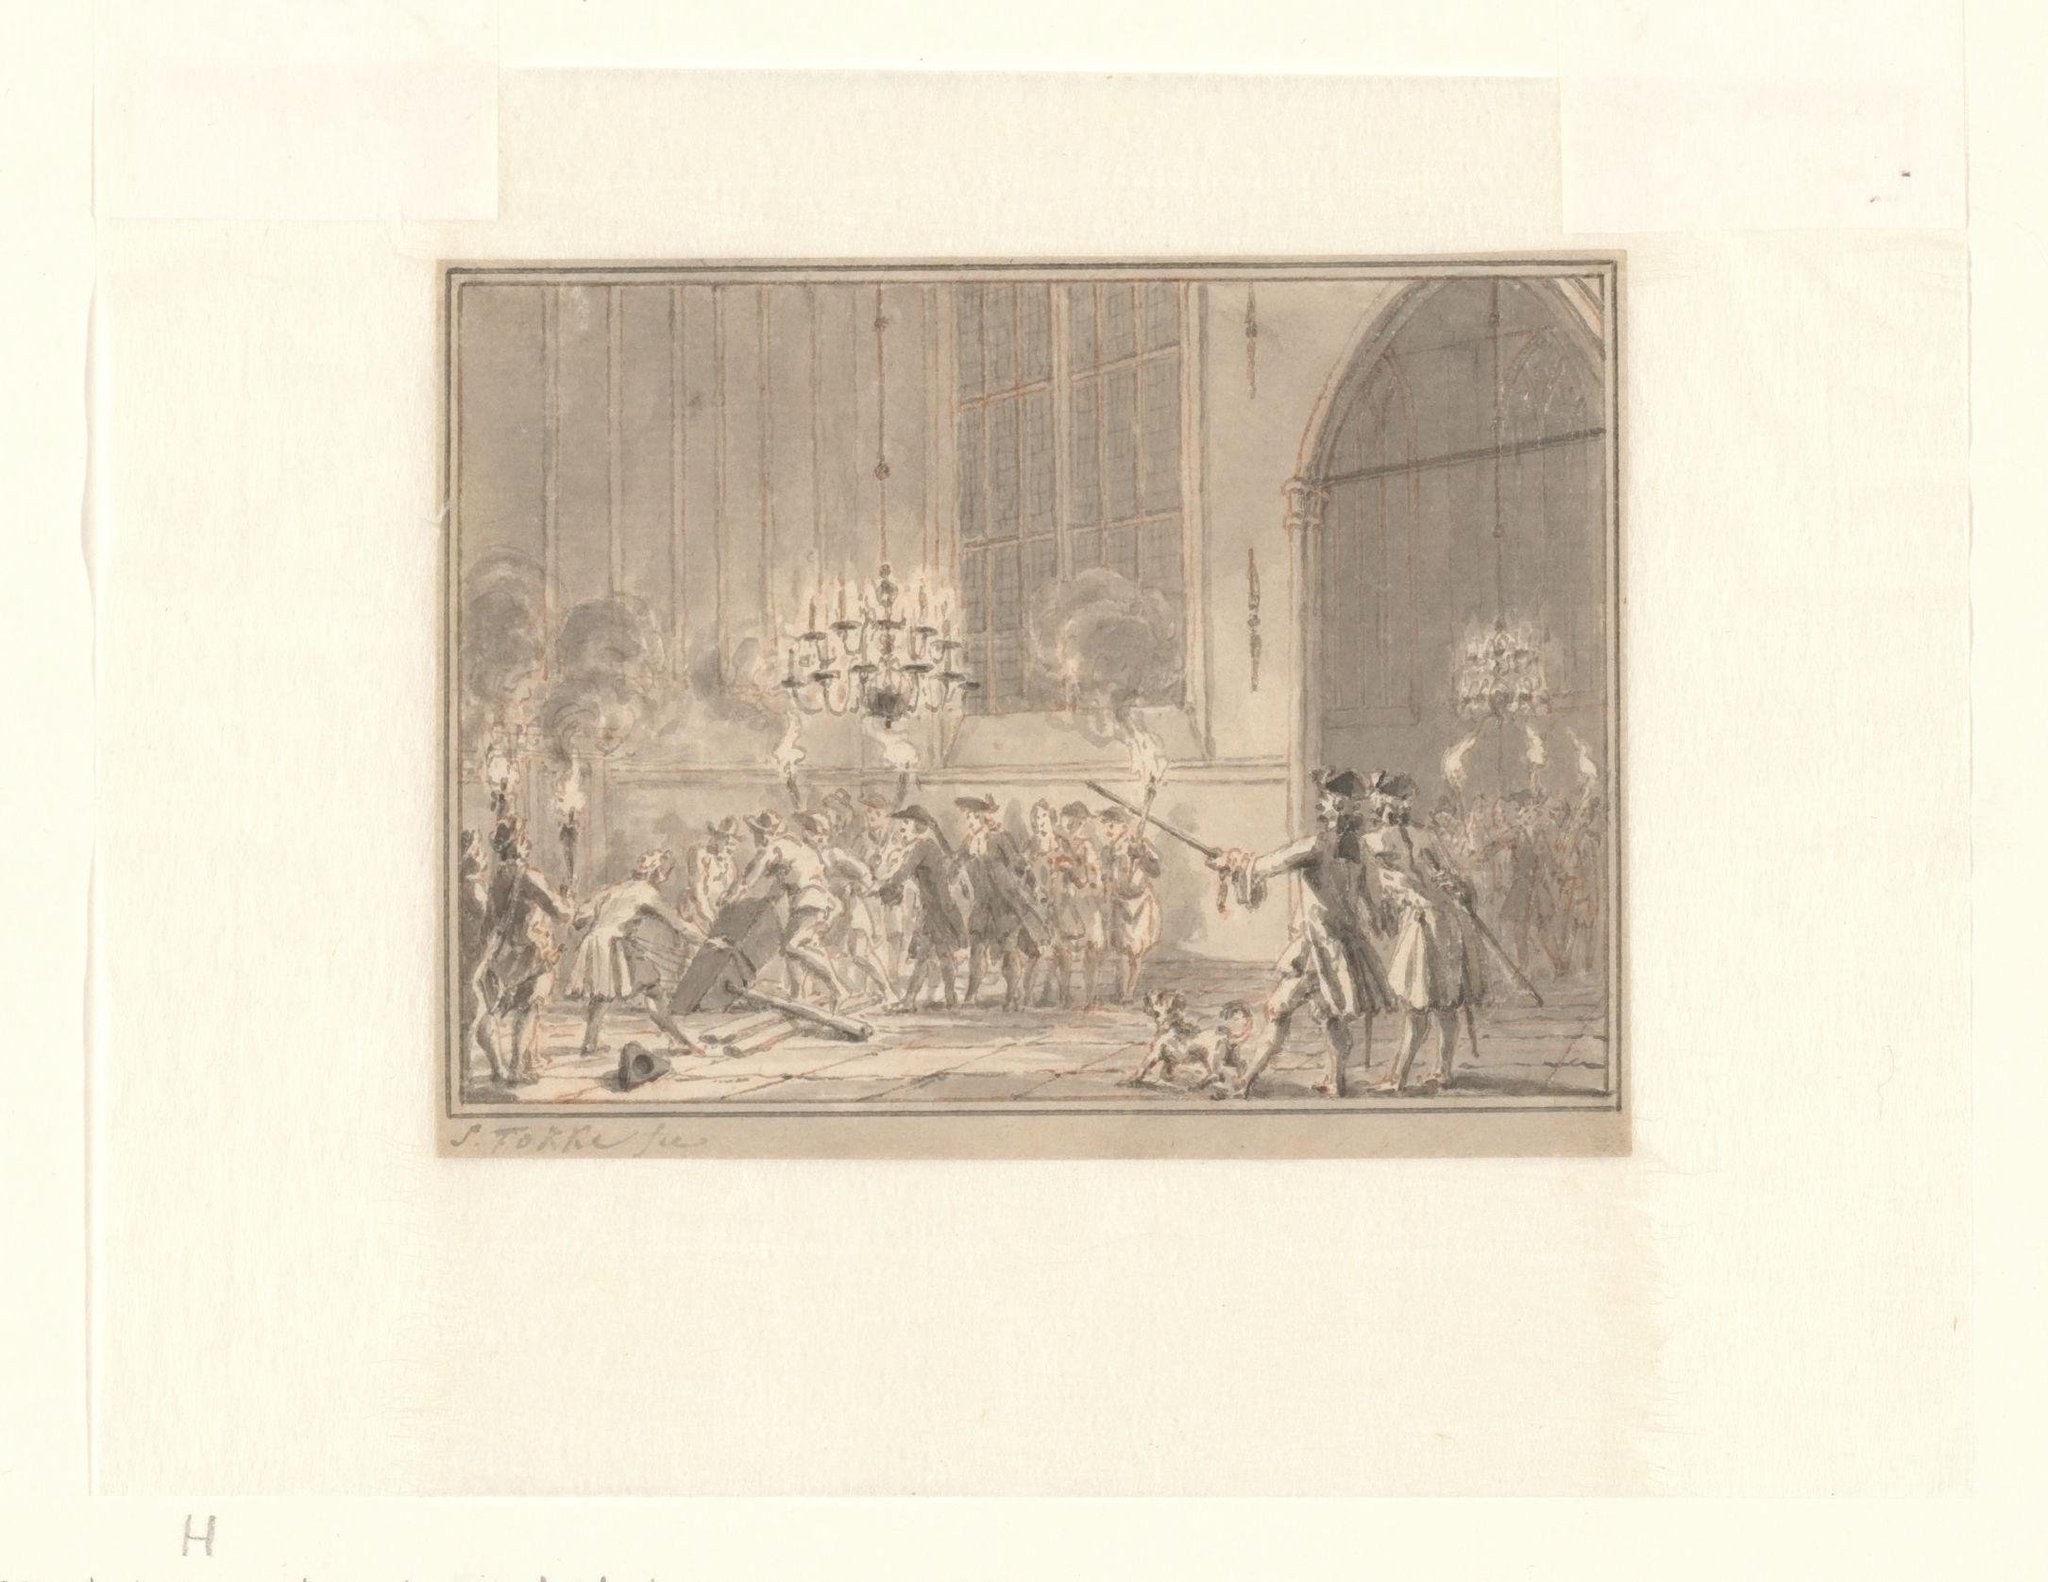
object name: drawing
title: Haastige begrafenis van koopman Daniël Raap in het geheim 's nachts in de Oude Kerk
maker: simon fokke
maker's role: draughtsman, print maker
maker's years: 1712-1784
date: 1754-1784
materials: ink, paper, pencil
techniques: brush, pen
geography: amsterdam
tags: burial, crowd, mob, city-view in general; 'veduta', street-fights, riots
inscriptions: signature: ‘S Fokke fec’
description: Ontwerptekening voor prent door Cornelis Brouwer, gebruikt in: Arend Fokke Simonsz. De vaderlandsche historie in themata. Amsterdam: Arend Fokke Simonsz., edities tussen 1783-ca. 1792.